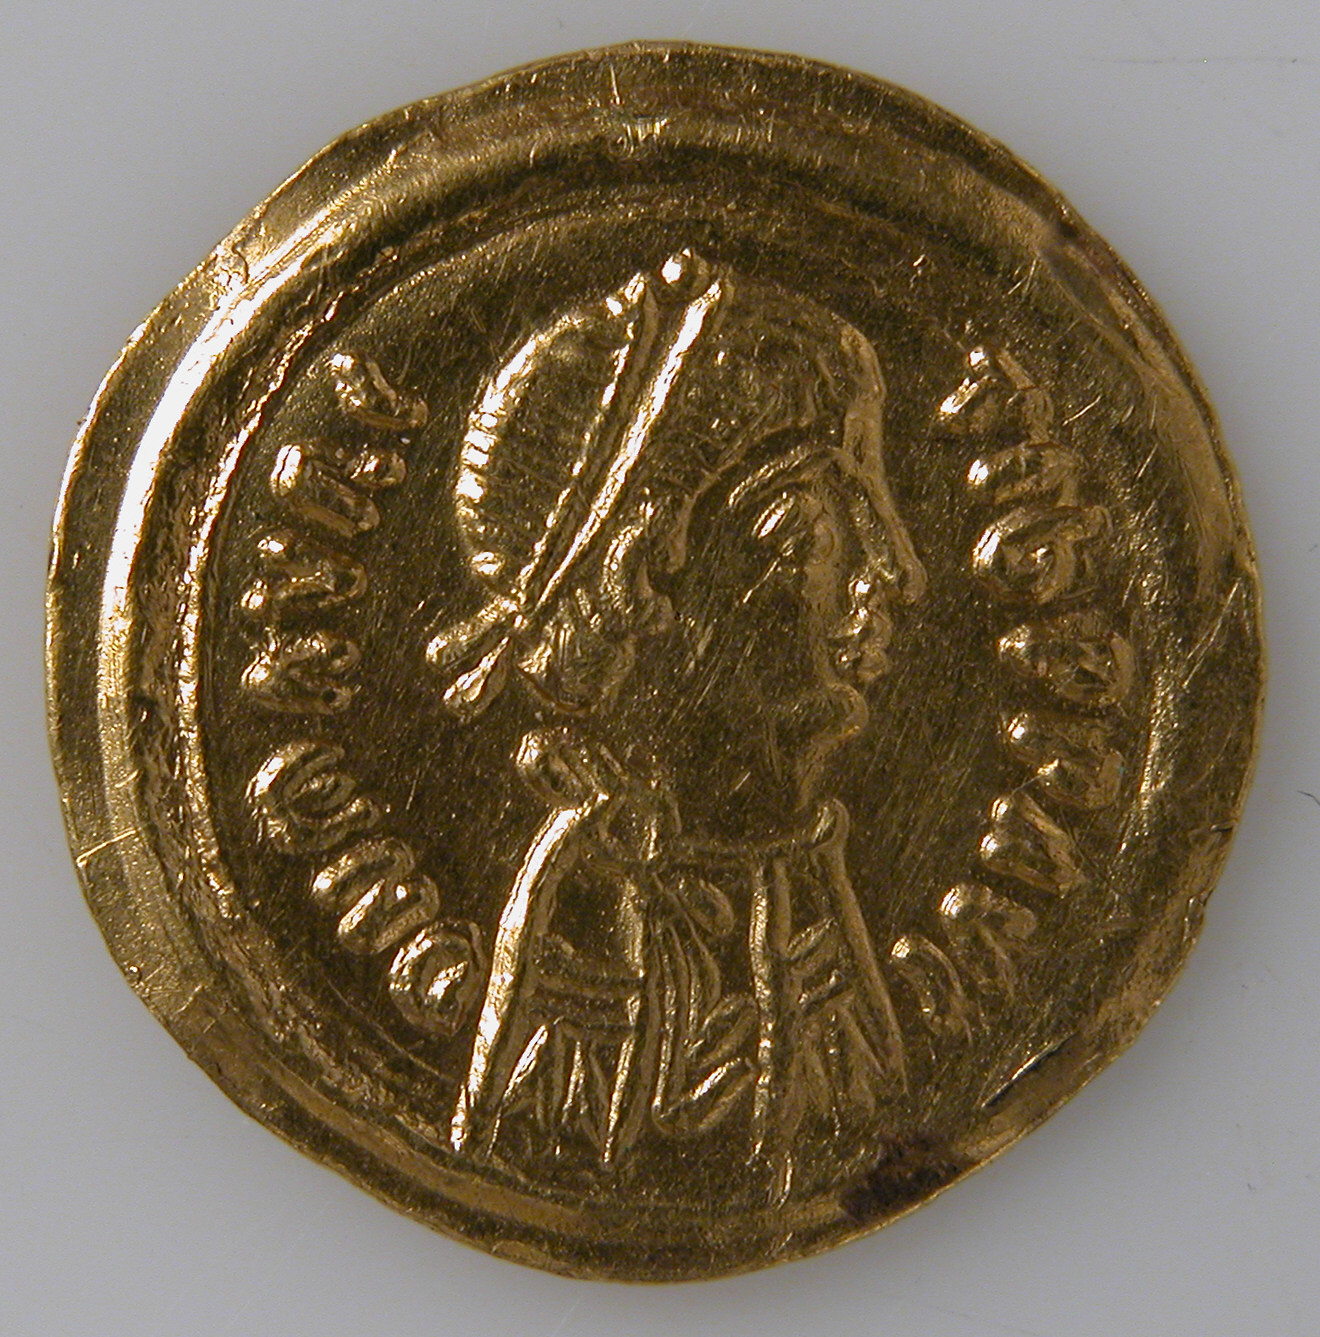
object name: tremissis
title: Tremissis of Justin Il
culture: byzantine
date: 565-578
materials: gold